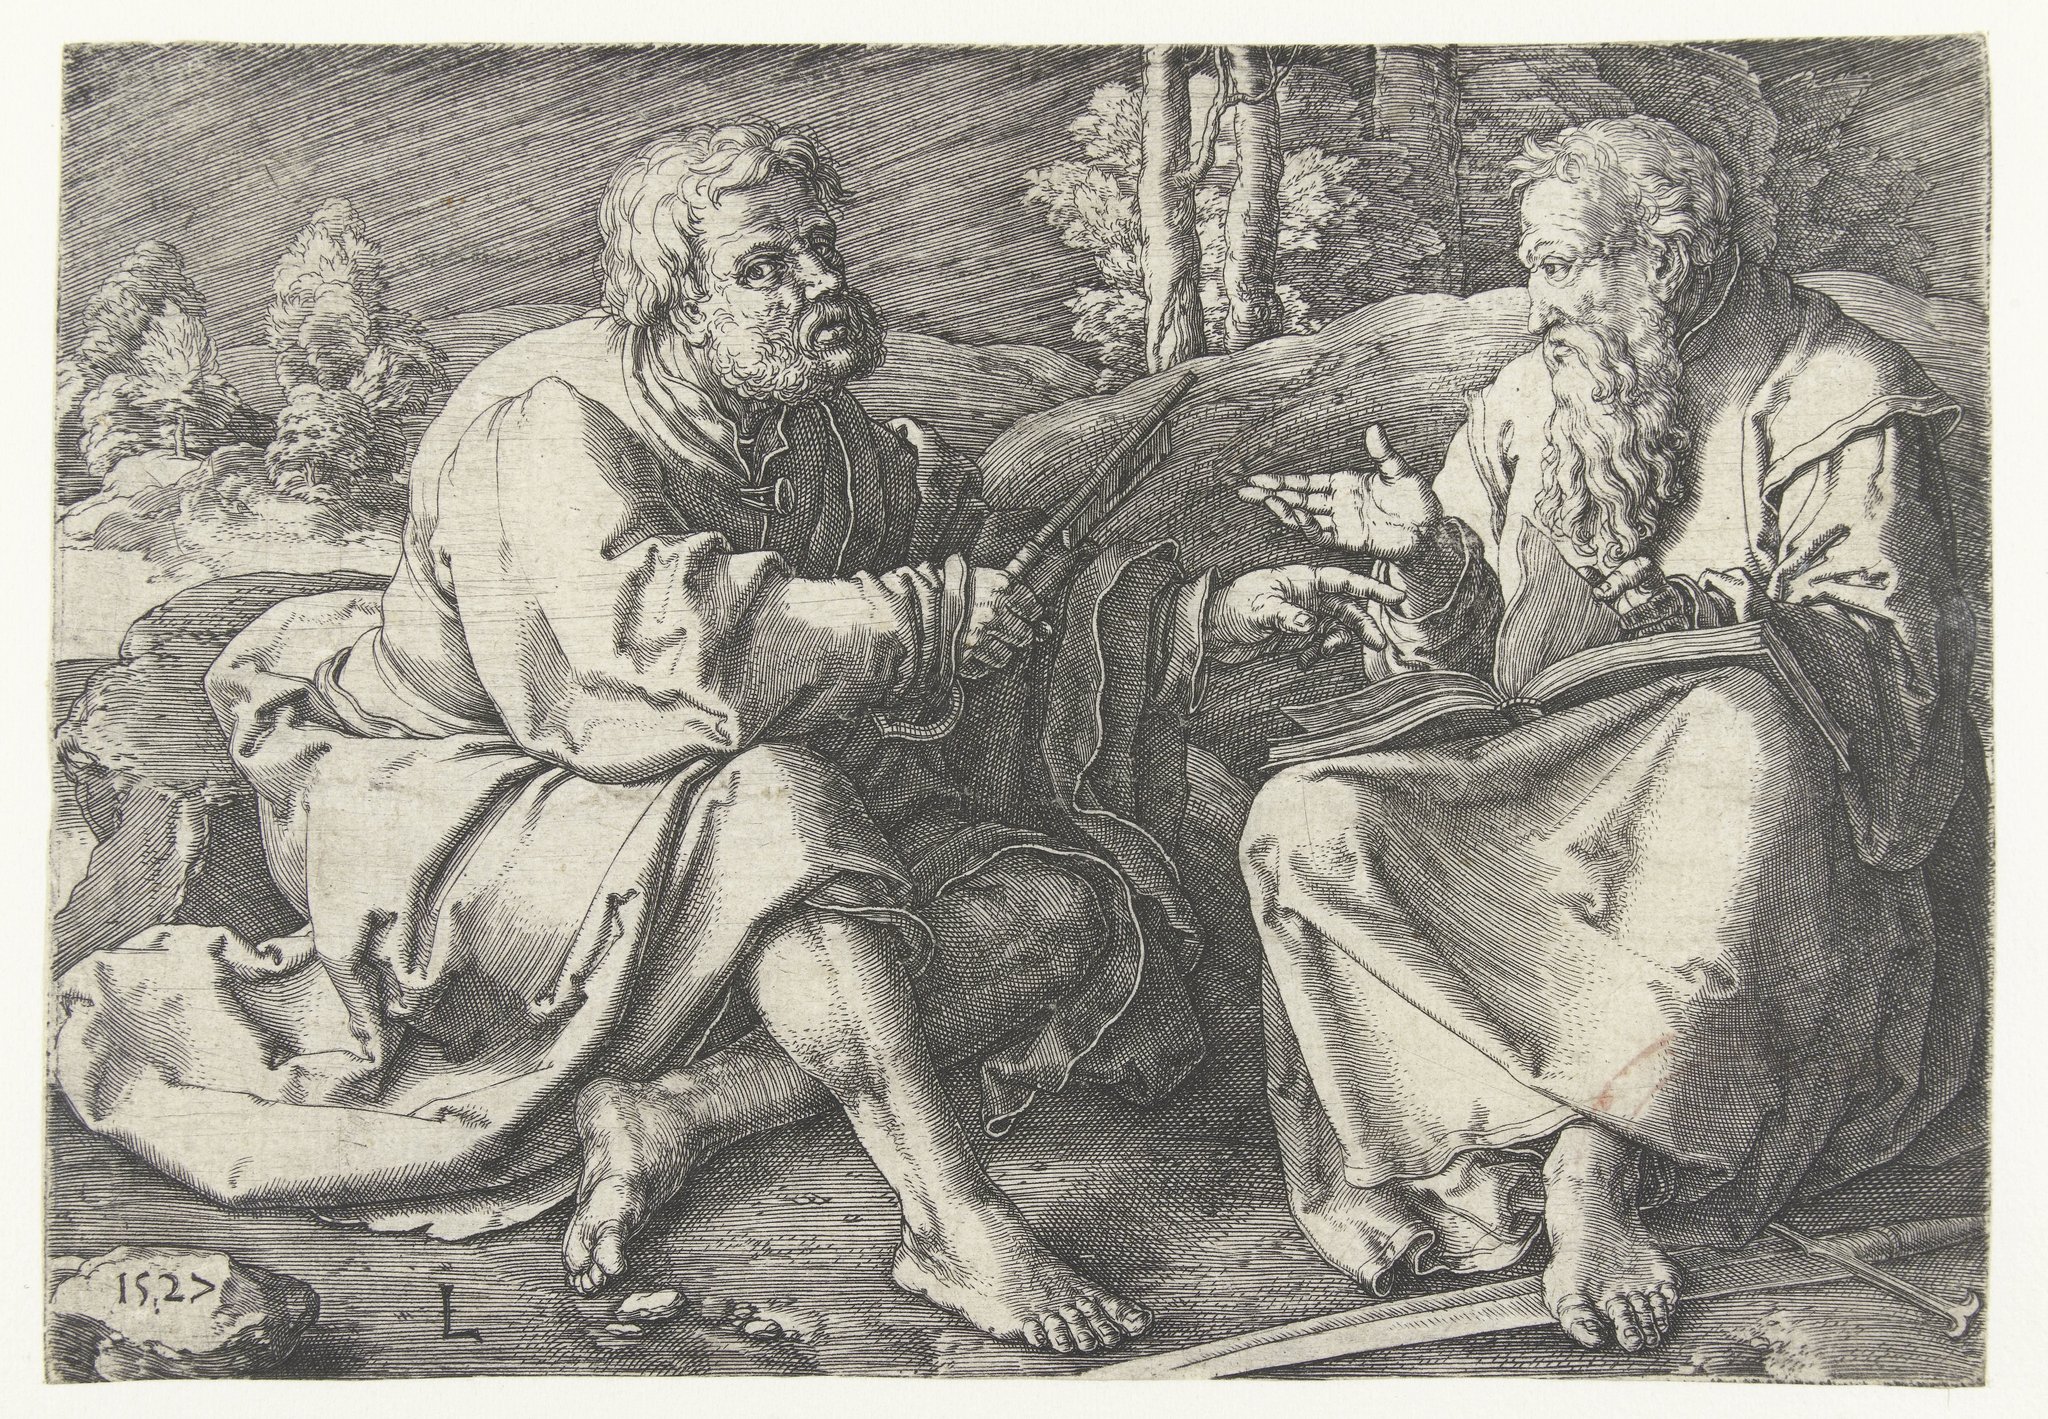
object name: print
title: Petrus en Paulus zittend in een landschap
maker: lucas van leyden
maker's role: draughtsman, painter, print maker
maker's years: 1494-1533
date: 1527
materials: paper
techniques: engraving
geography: low countries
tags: paul and peter disputing in antioch (galatians 2:11-14)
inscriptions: collector's mark: Lugt 240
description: Petrus, met sleutel in hand, in discussie met Paulus met zwaard onder voet en boek op schoot.